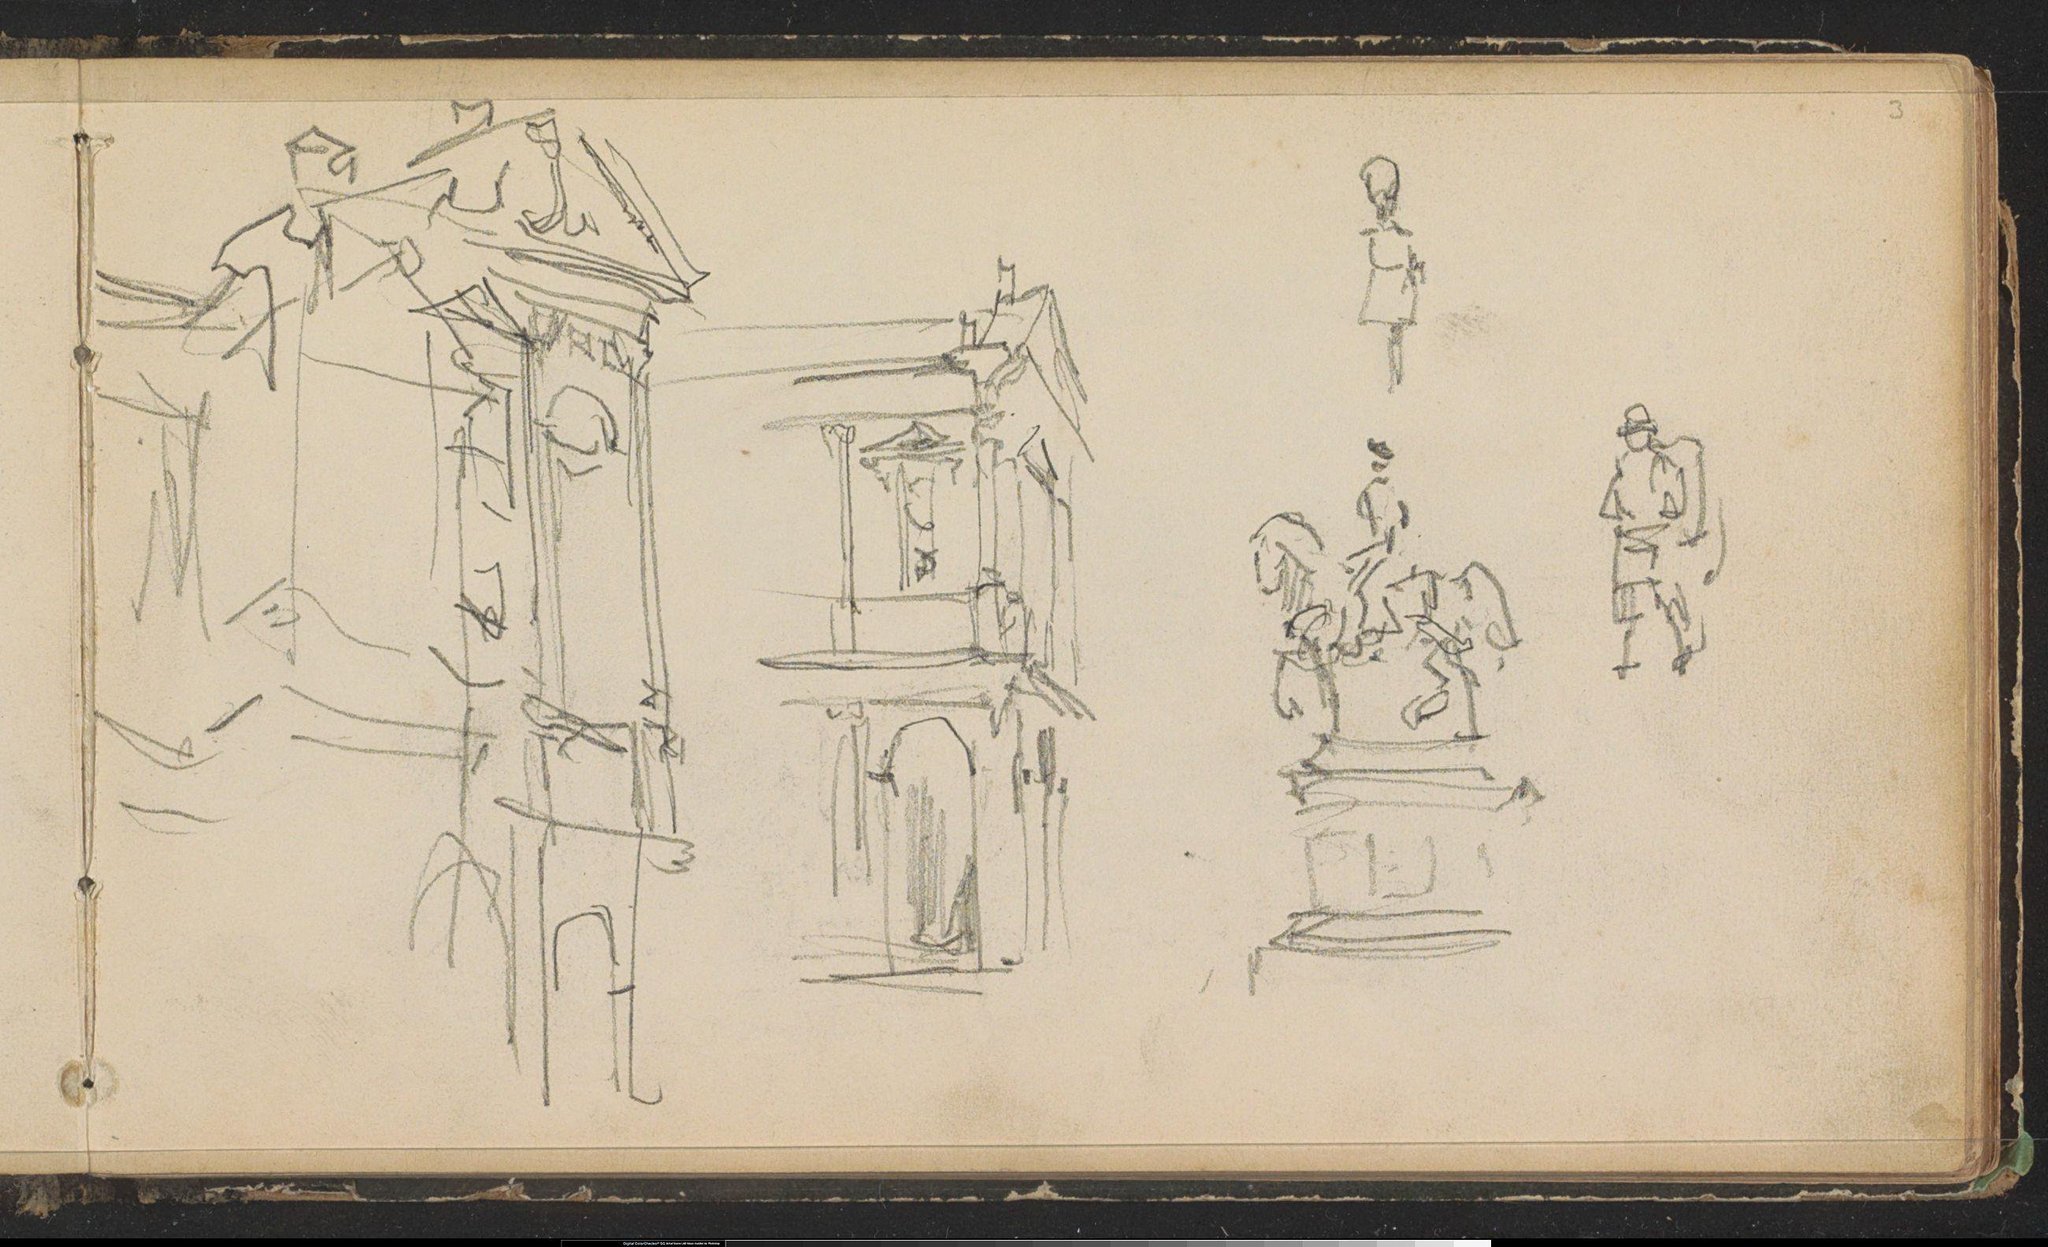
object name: sketchbook leaf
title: Standbeeld van Willem van Oranje voor Paleis Noordeinde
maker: johannes bosboom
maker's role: draughtsman, painter, print maker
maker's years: 1817-1891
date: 1845-1891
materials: paper, pencil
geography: the hague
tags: monument, statue, hôtel, i.e. small palace in city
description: Blad 3 recto uit een schetsboek met 46 bladen.